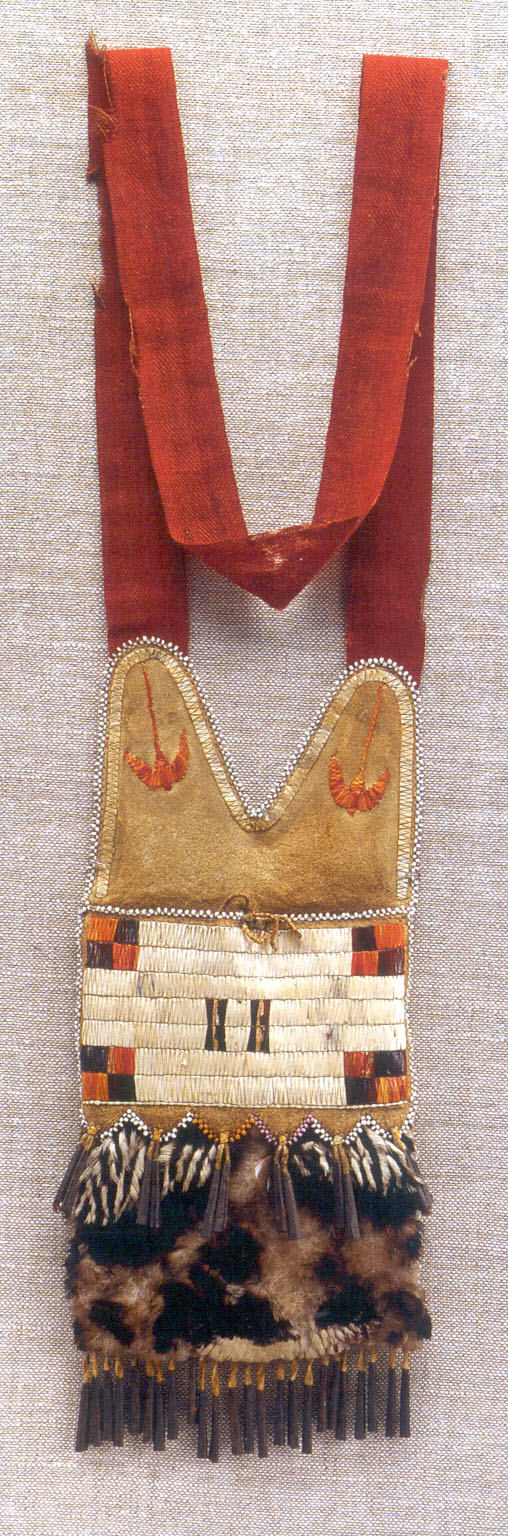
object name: bag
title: Shot Pouch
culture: mesquakie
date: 1801-1833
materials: cotton, glass, metal, skin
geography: united states